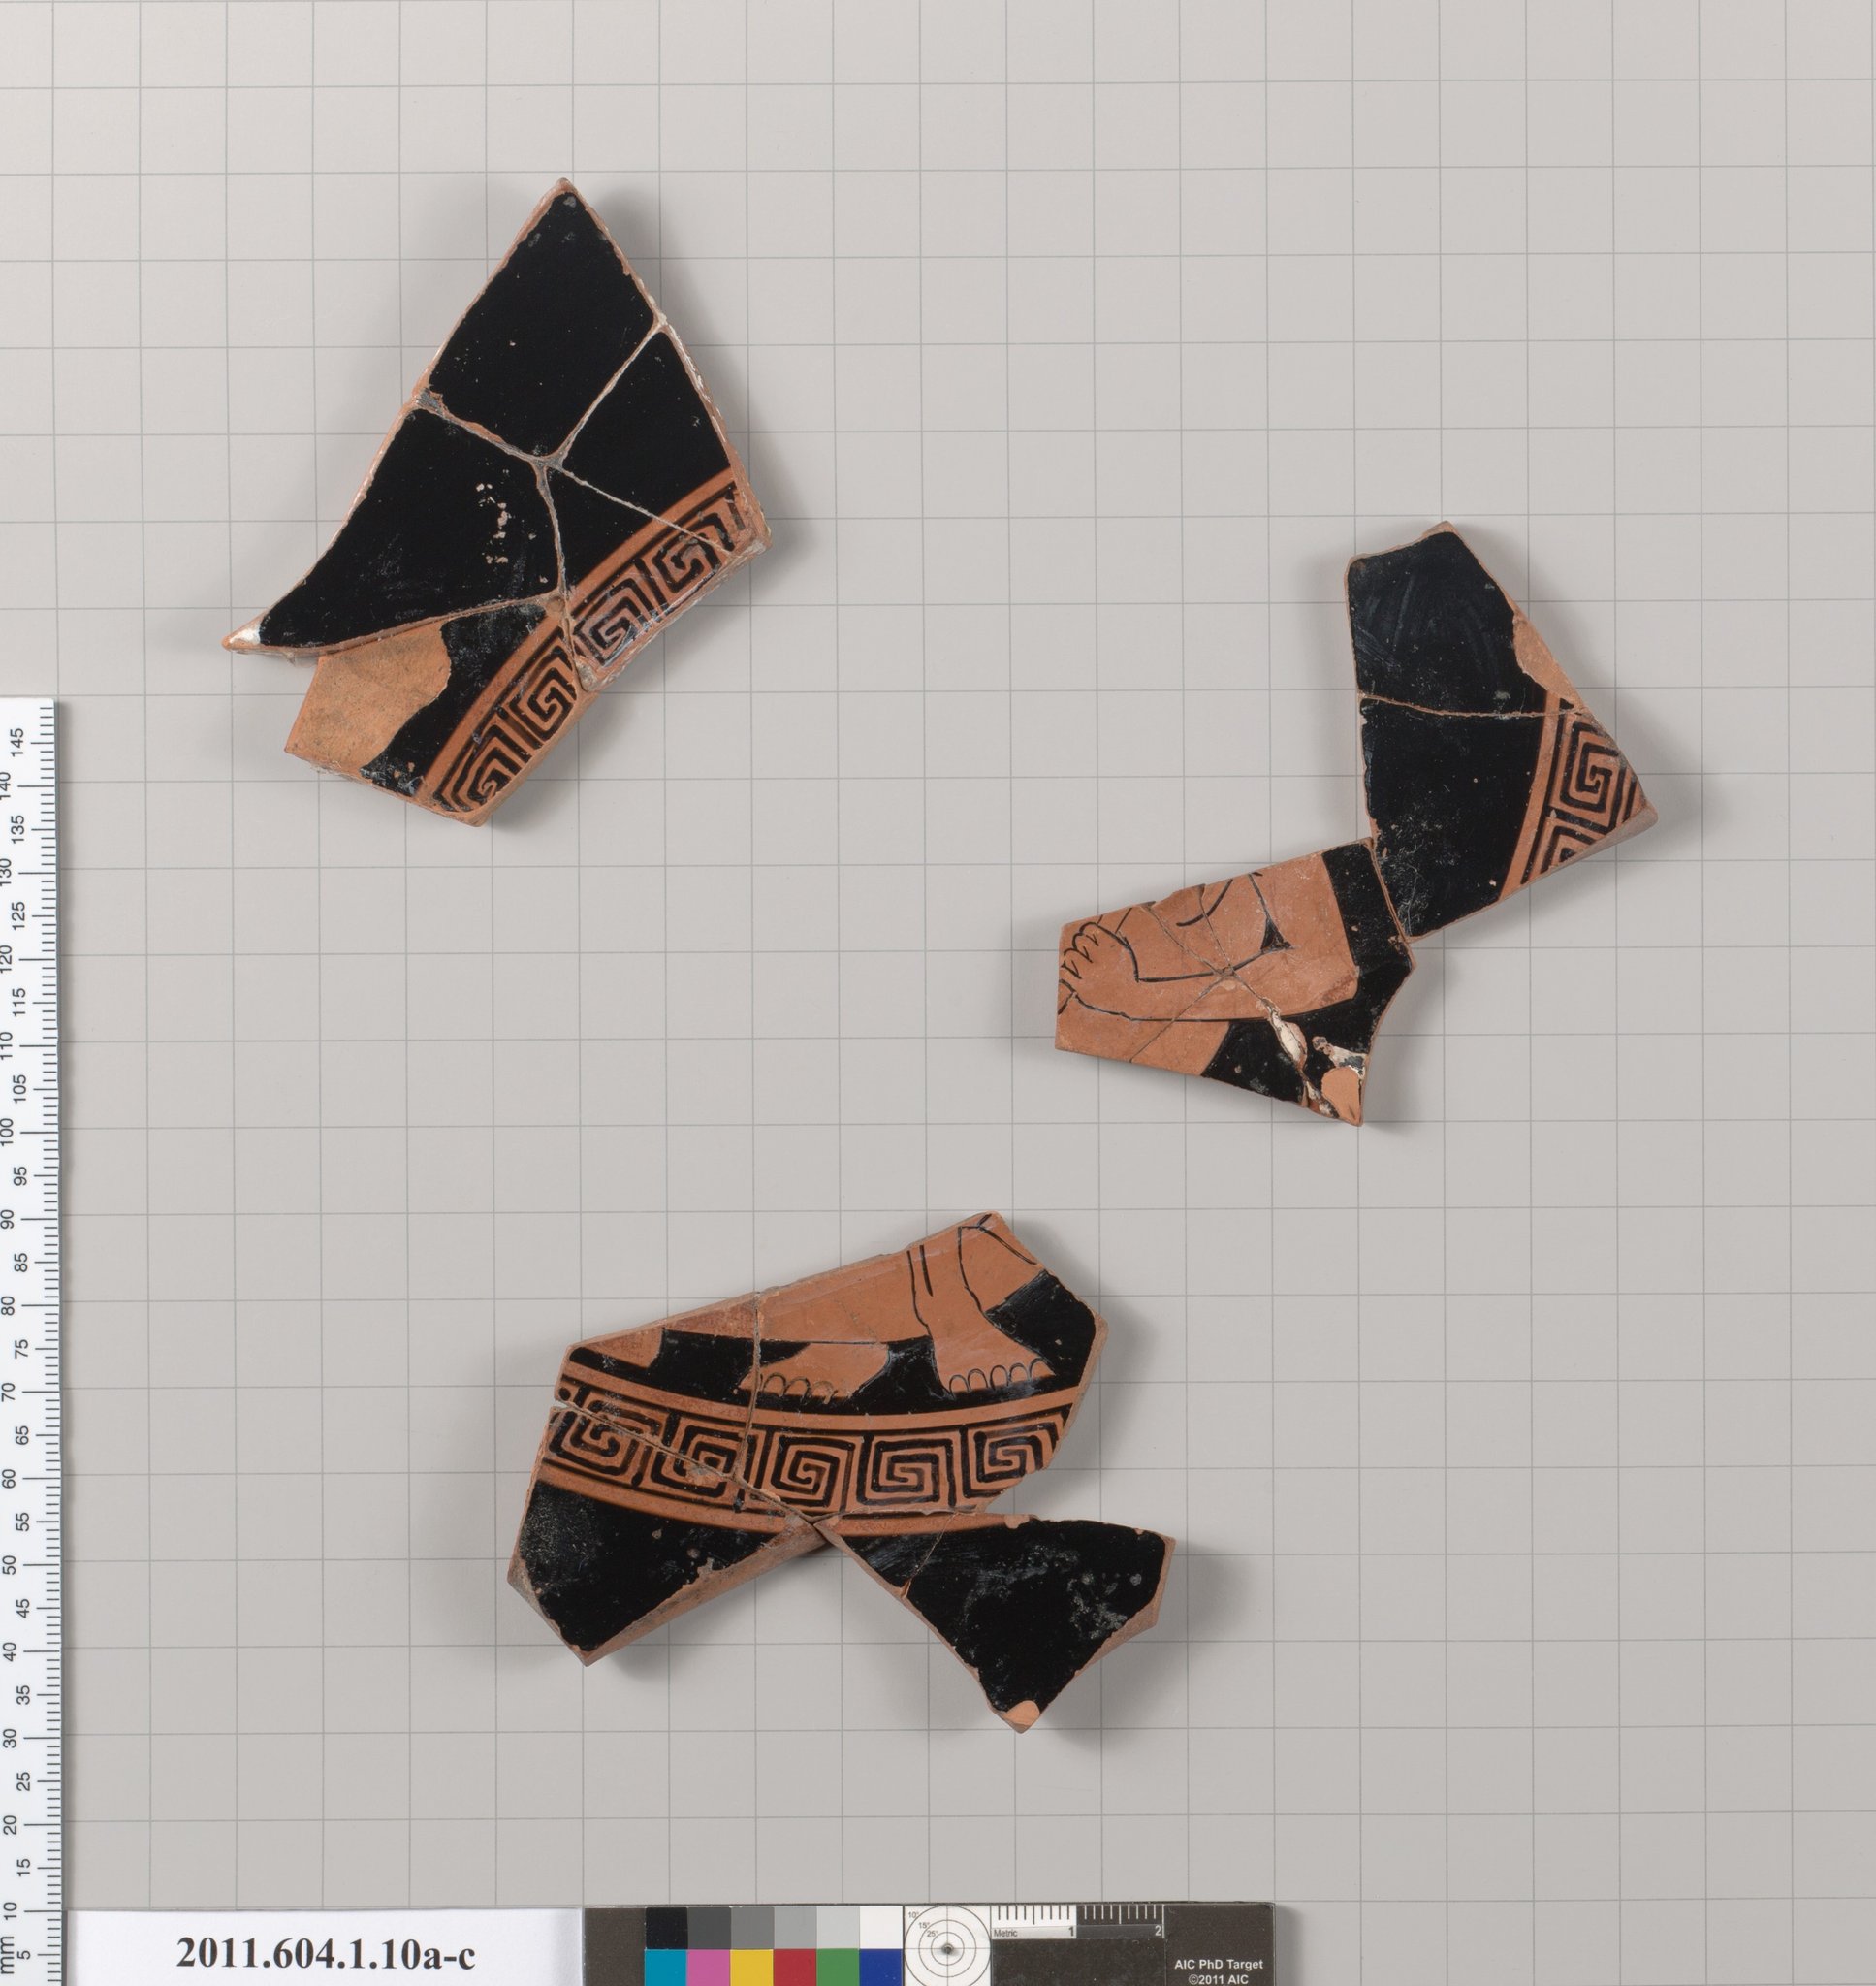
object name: kylix fragment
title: Terracotta fragments of a kylix (drinking cup)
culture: greek, attic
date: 480-470 BCE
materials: terracotta